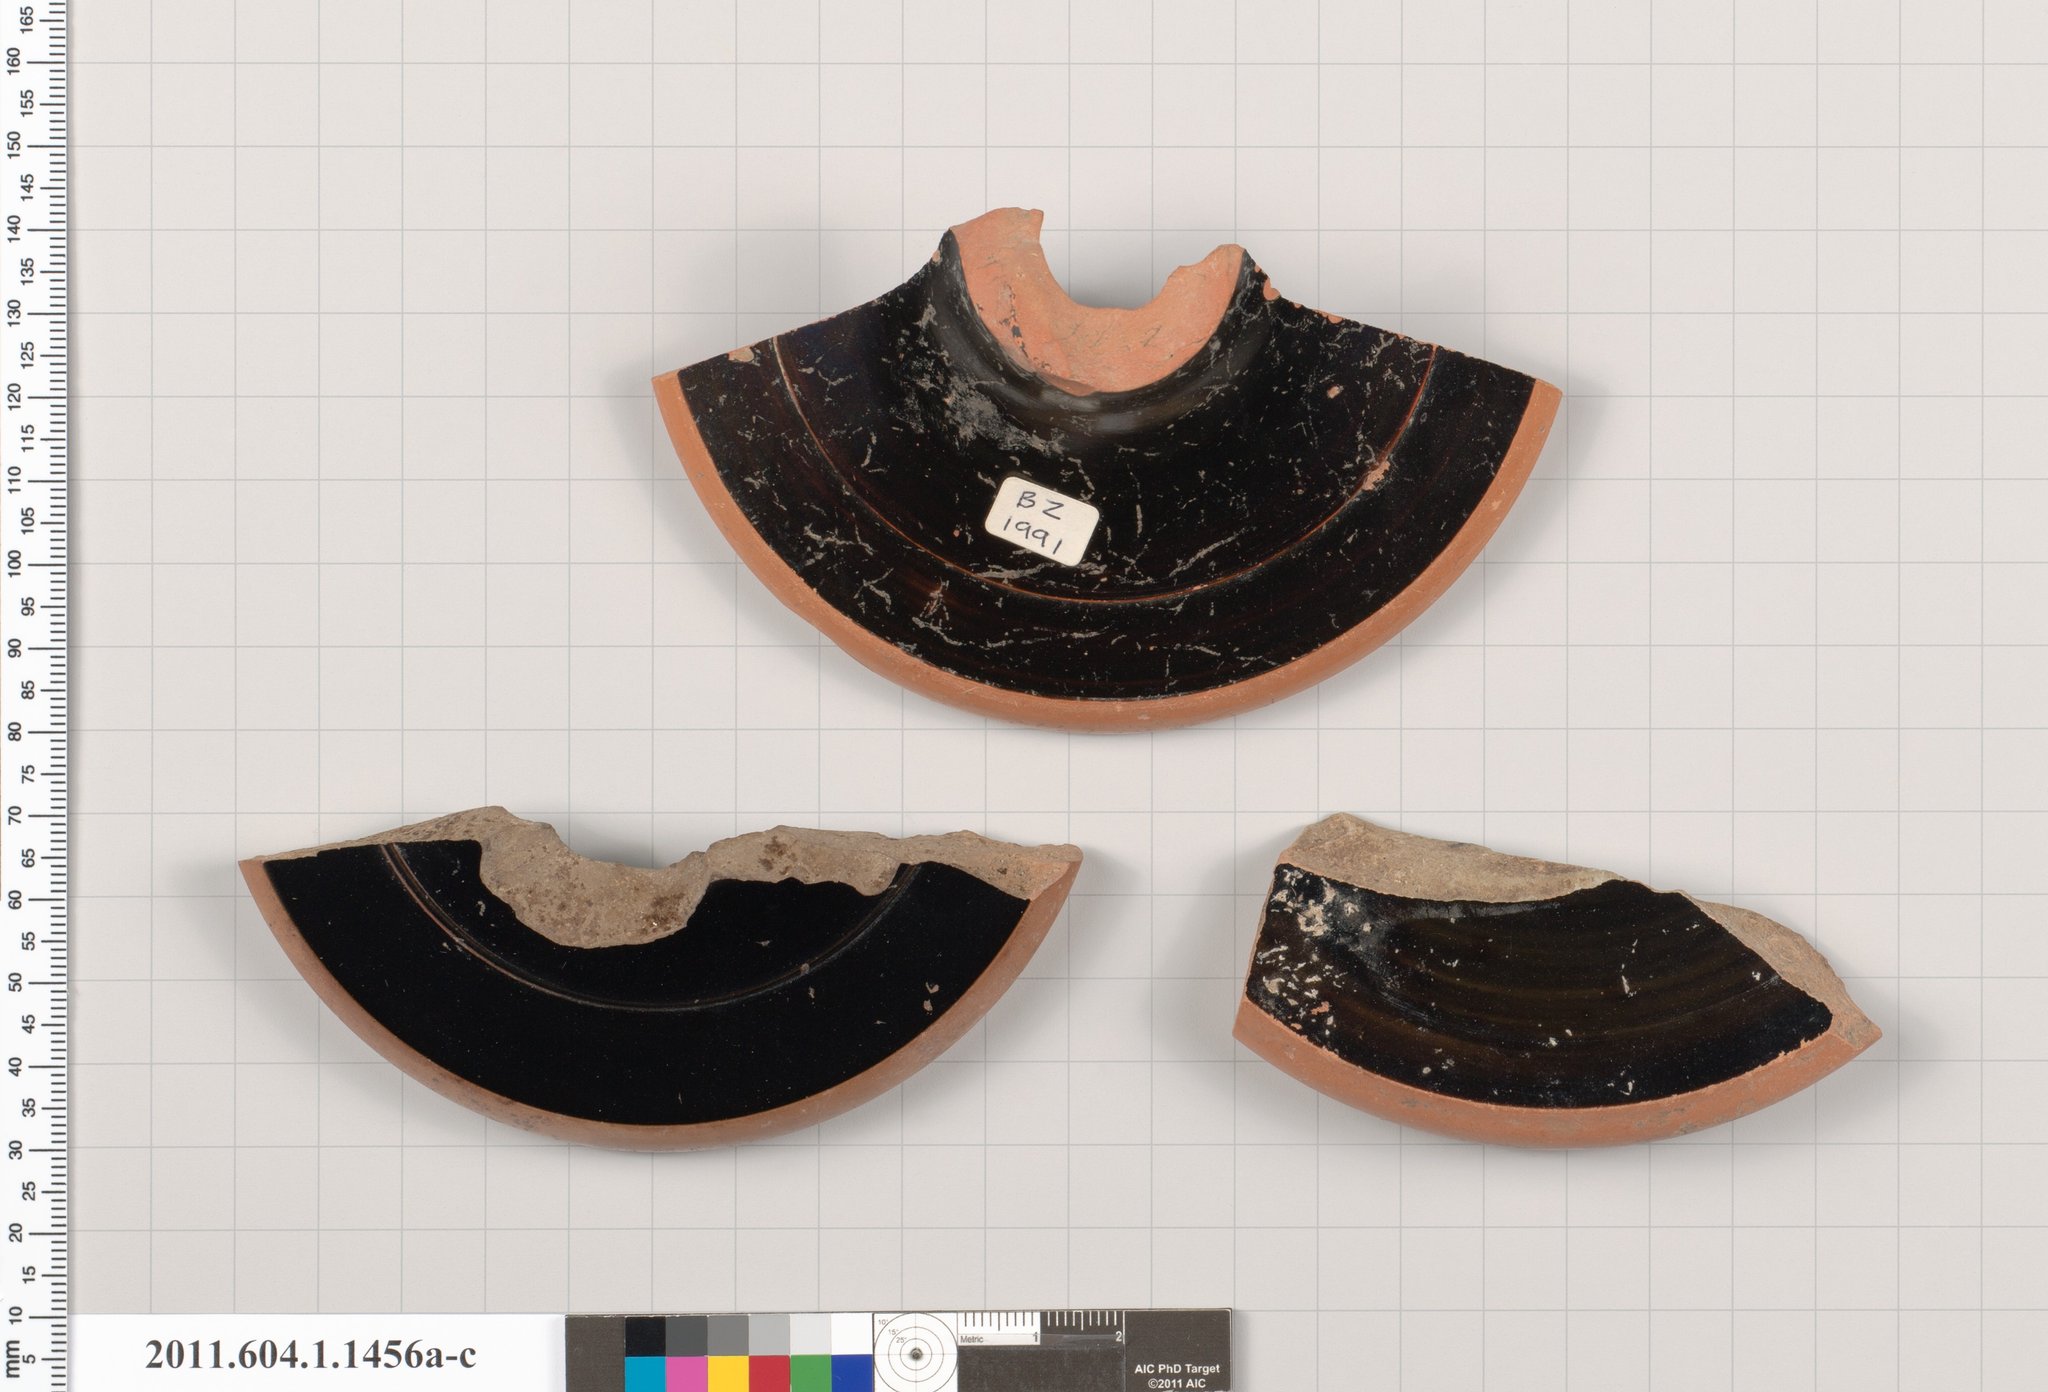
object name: kylix fragment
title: Terracotta fragments of kylikes (drinking cups)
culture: greek, attic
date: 500-401 BCE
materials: terracotta